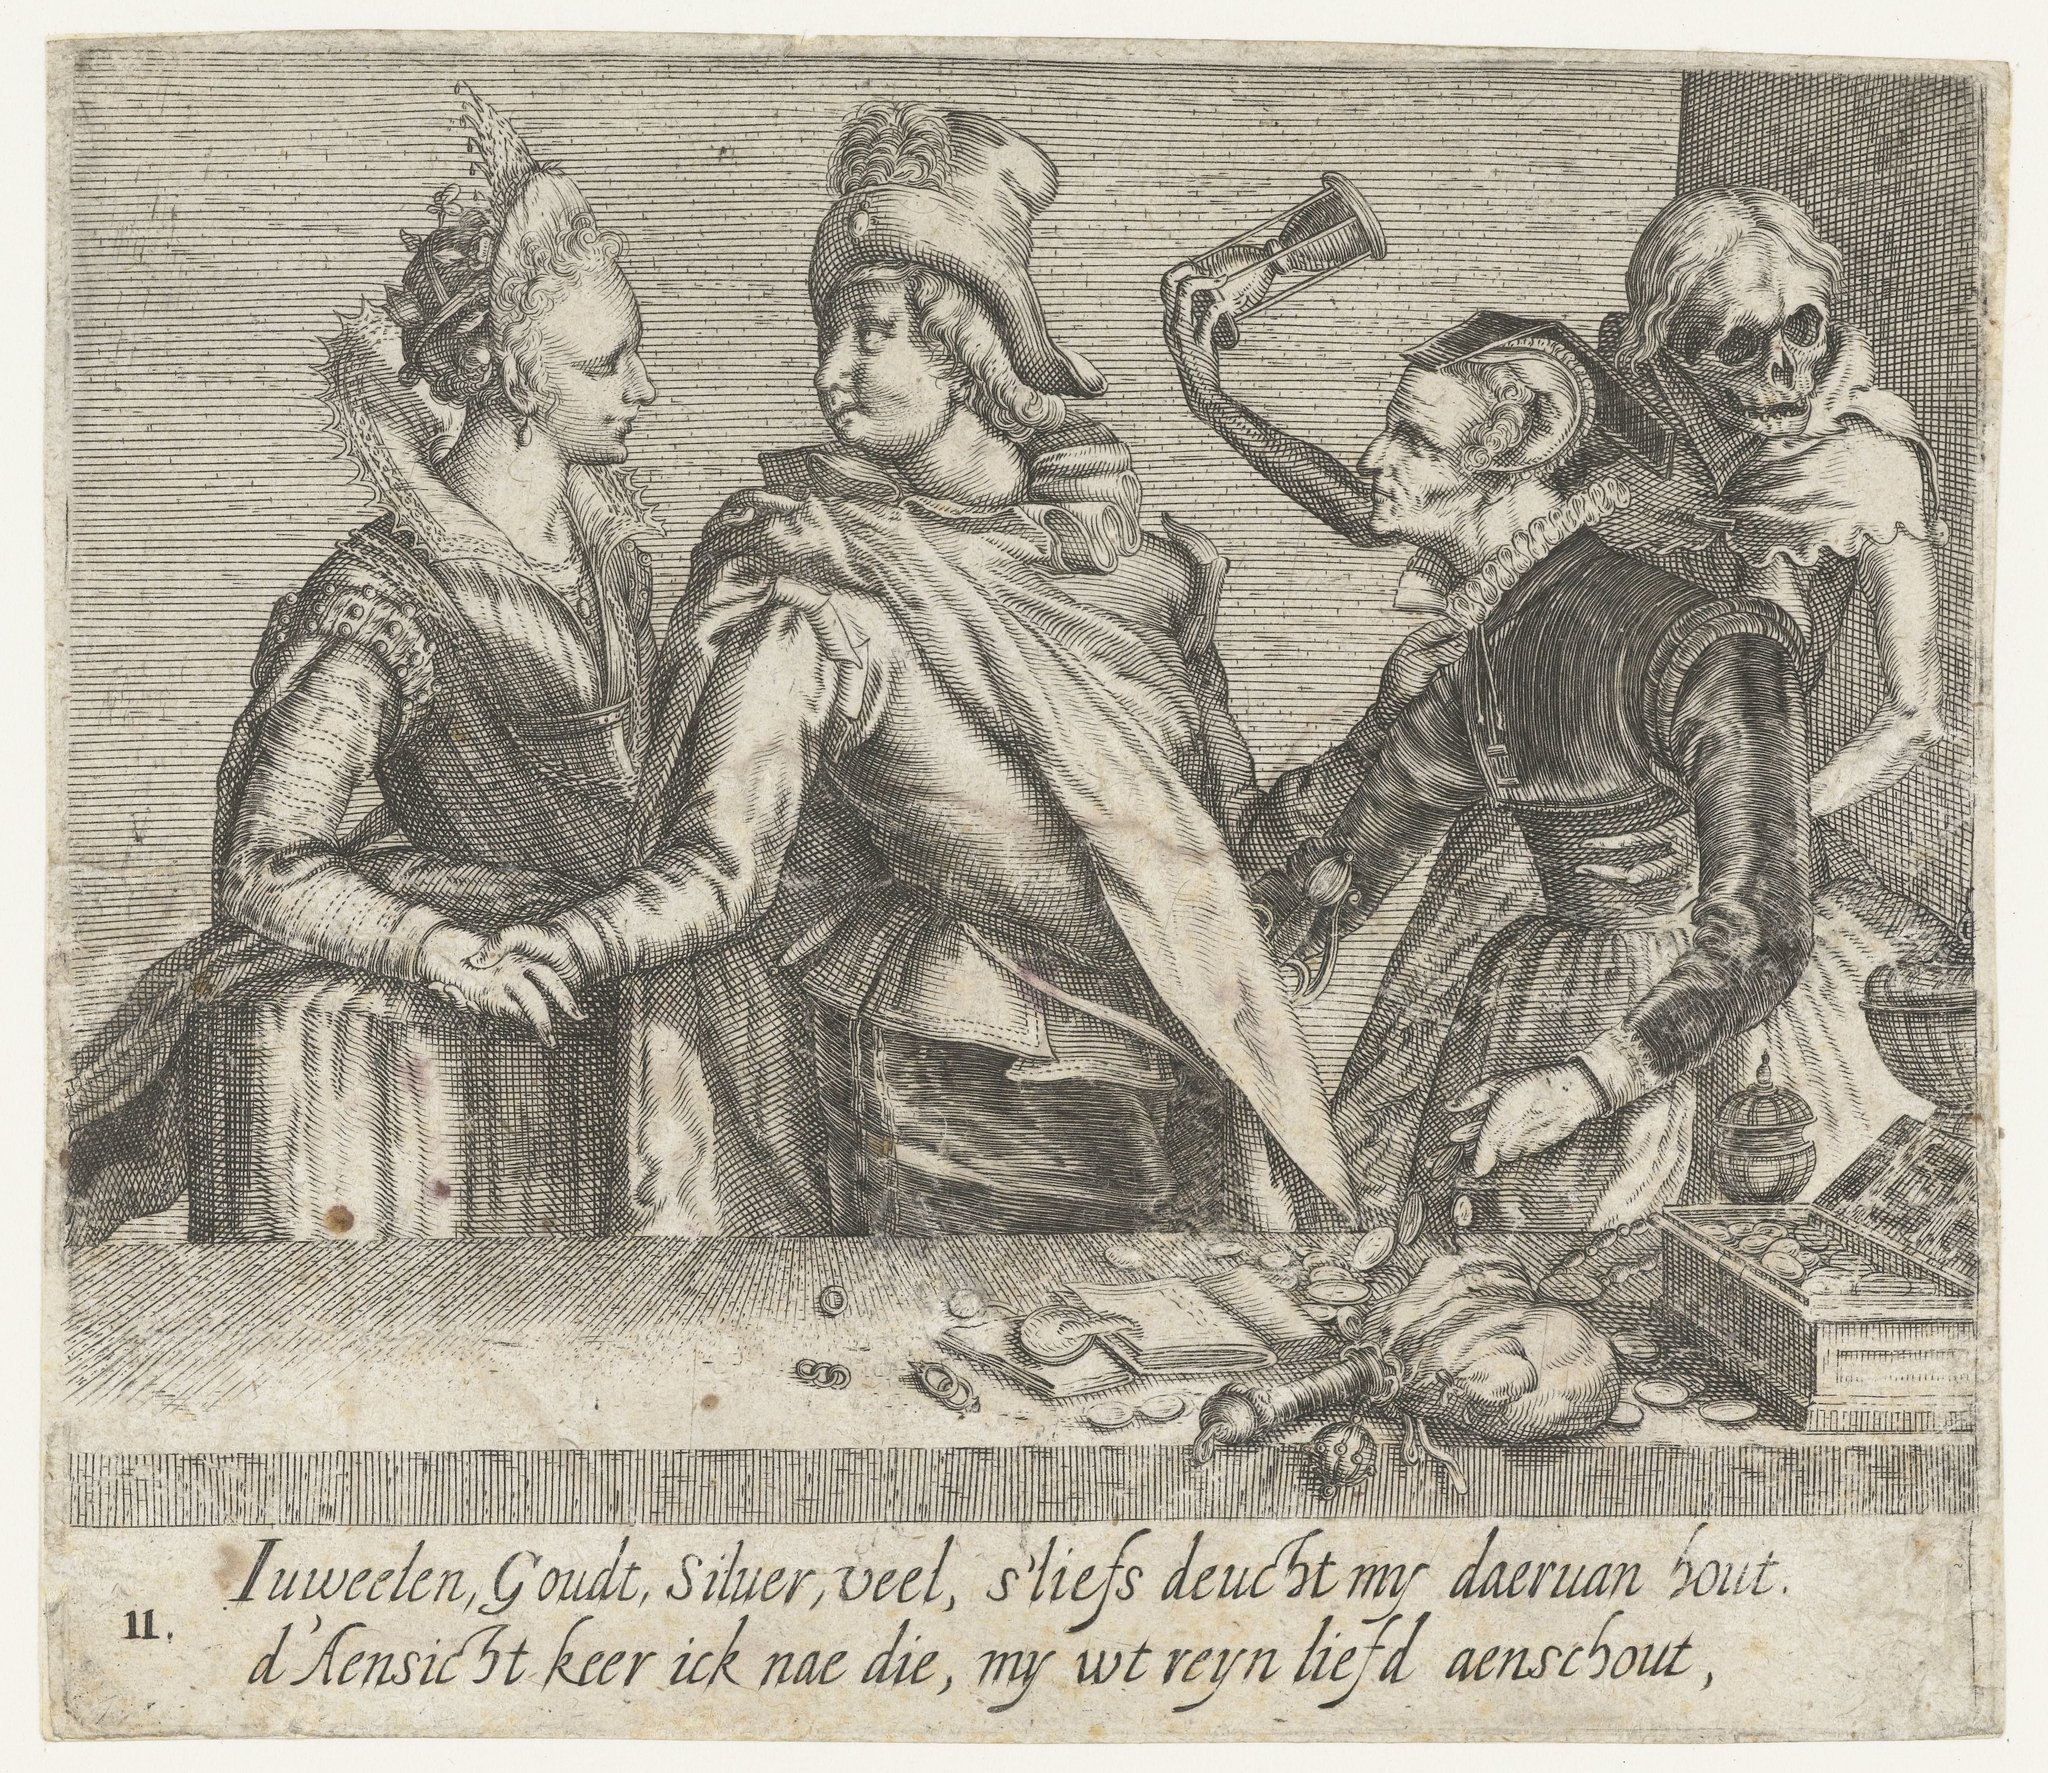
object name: print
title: True Love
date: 1608-1612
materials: paper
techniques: engraving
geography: the hague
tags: unequal partners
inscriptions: collector's mark: Lugt 1918ter, collector's mark: Lugt 2228a, collector's mark: Lugt 2760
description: Here an eligible young man is being propositioned with money by a much older woman on the right. But in spite of her wealth (and her apparent imminent death), he rejects her offer and turns to the virtuous young woman who really loves him. He is clearly making a big financial sacrifice.